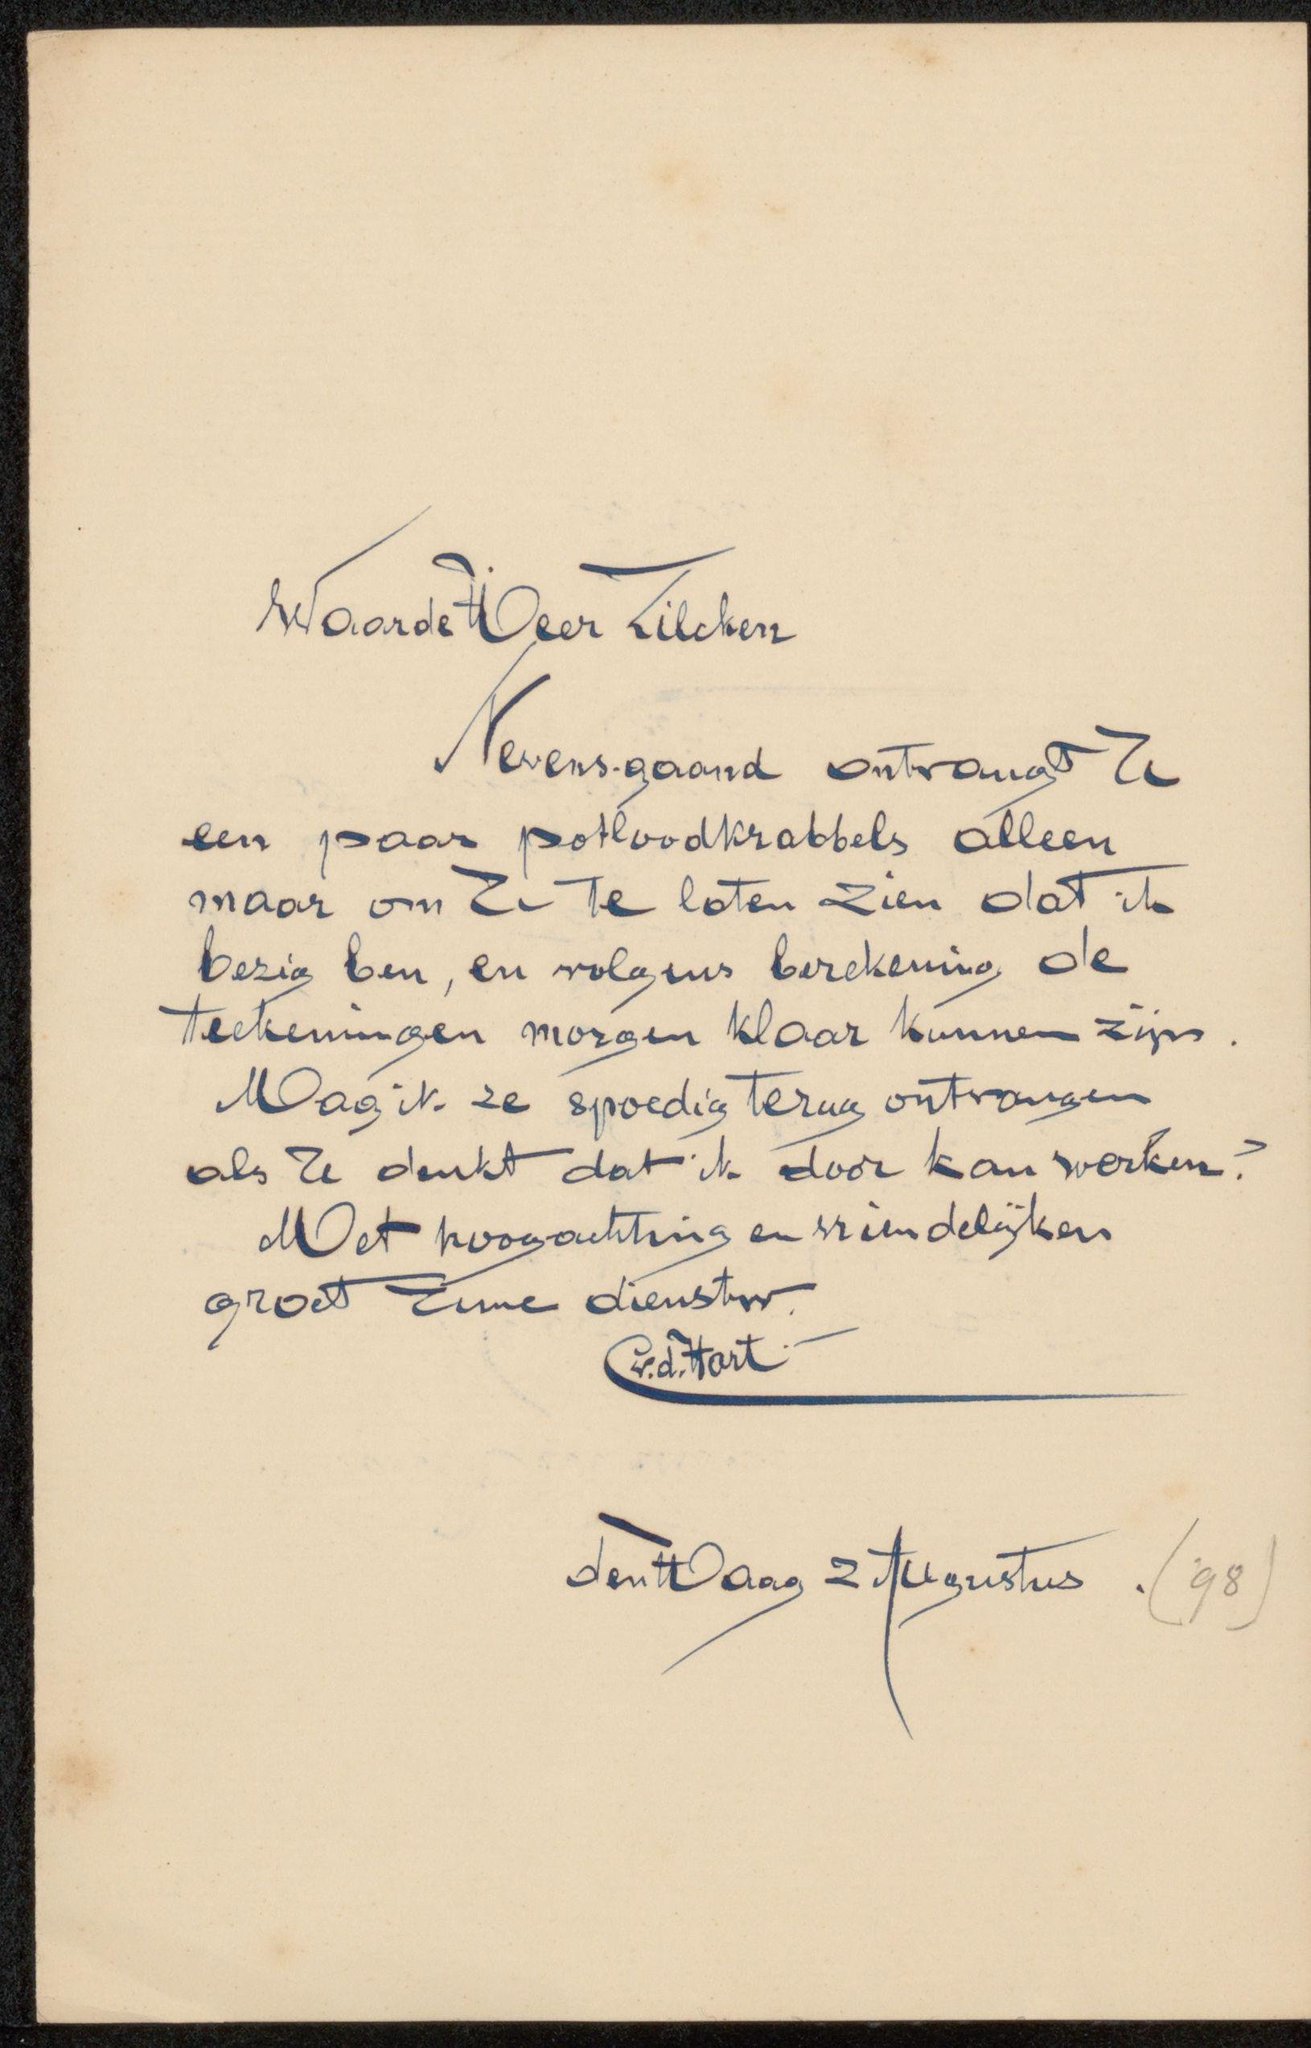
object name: letter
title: Brief aan Philip Zilcken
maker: cornelia van der hart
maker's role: print maker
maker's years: 1851-1940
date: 1861-1930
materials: ink, paper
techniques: pen, writing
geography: the hague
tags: the hague, painter, draughtsman, philip zilcken, drawing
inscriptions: collector's mark: ‘RPK’